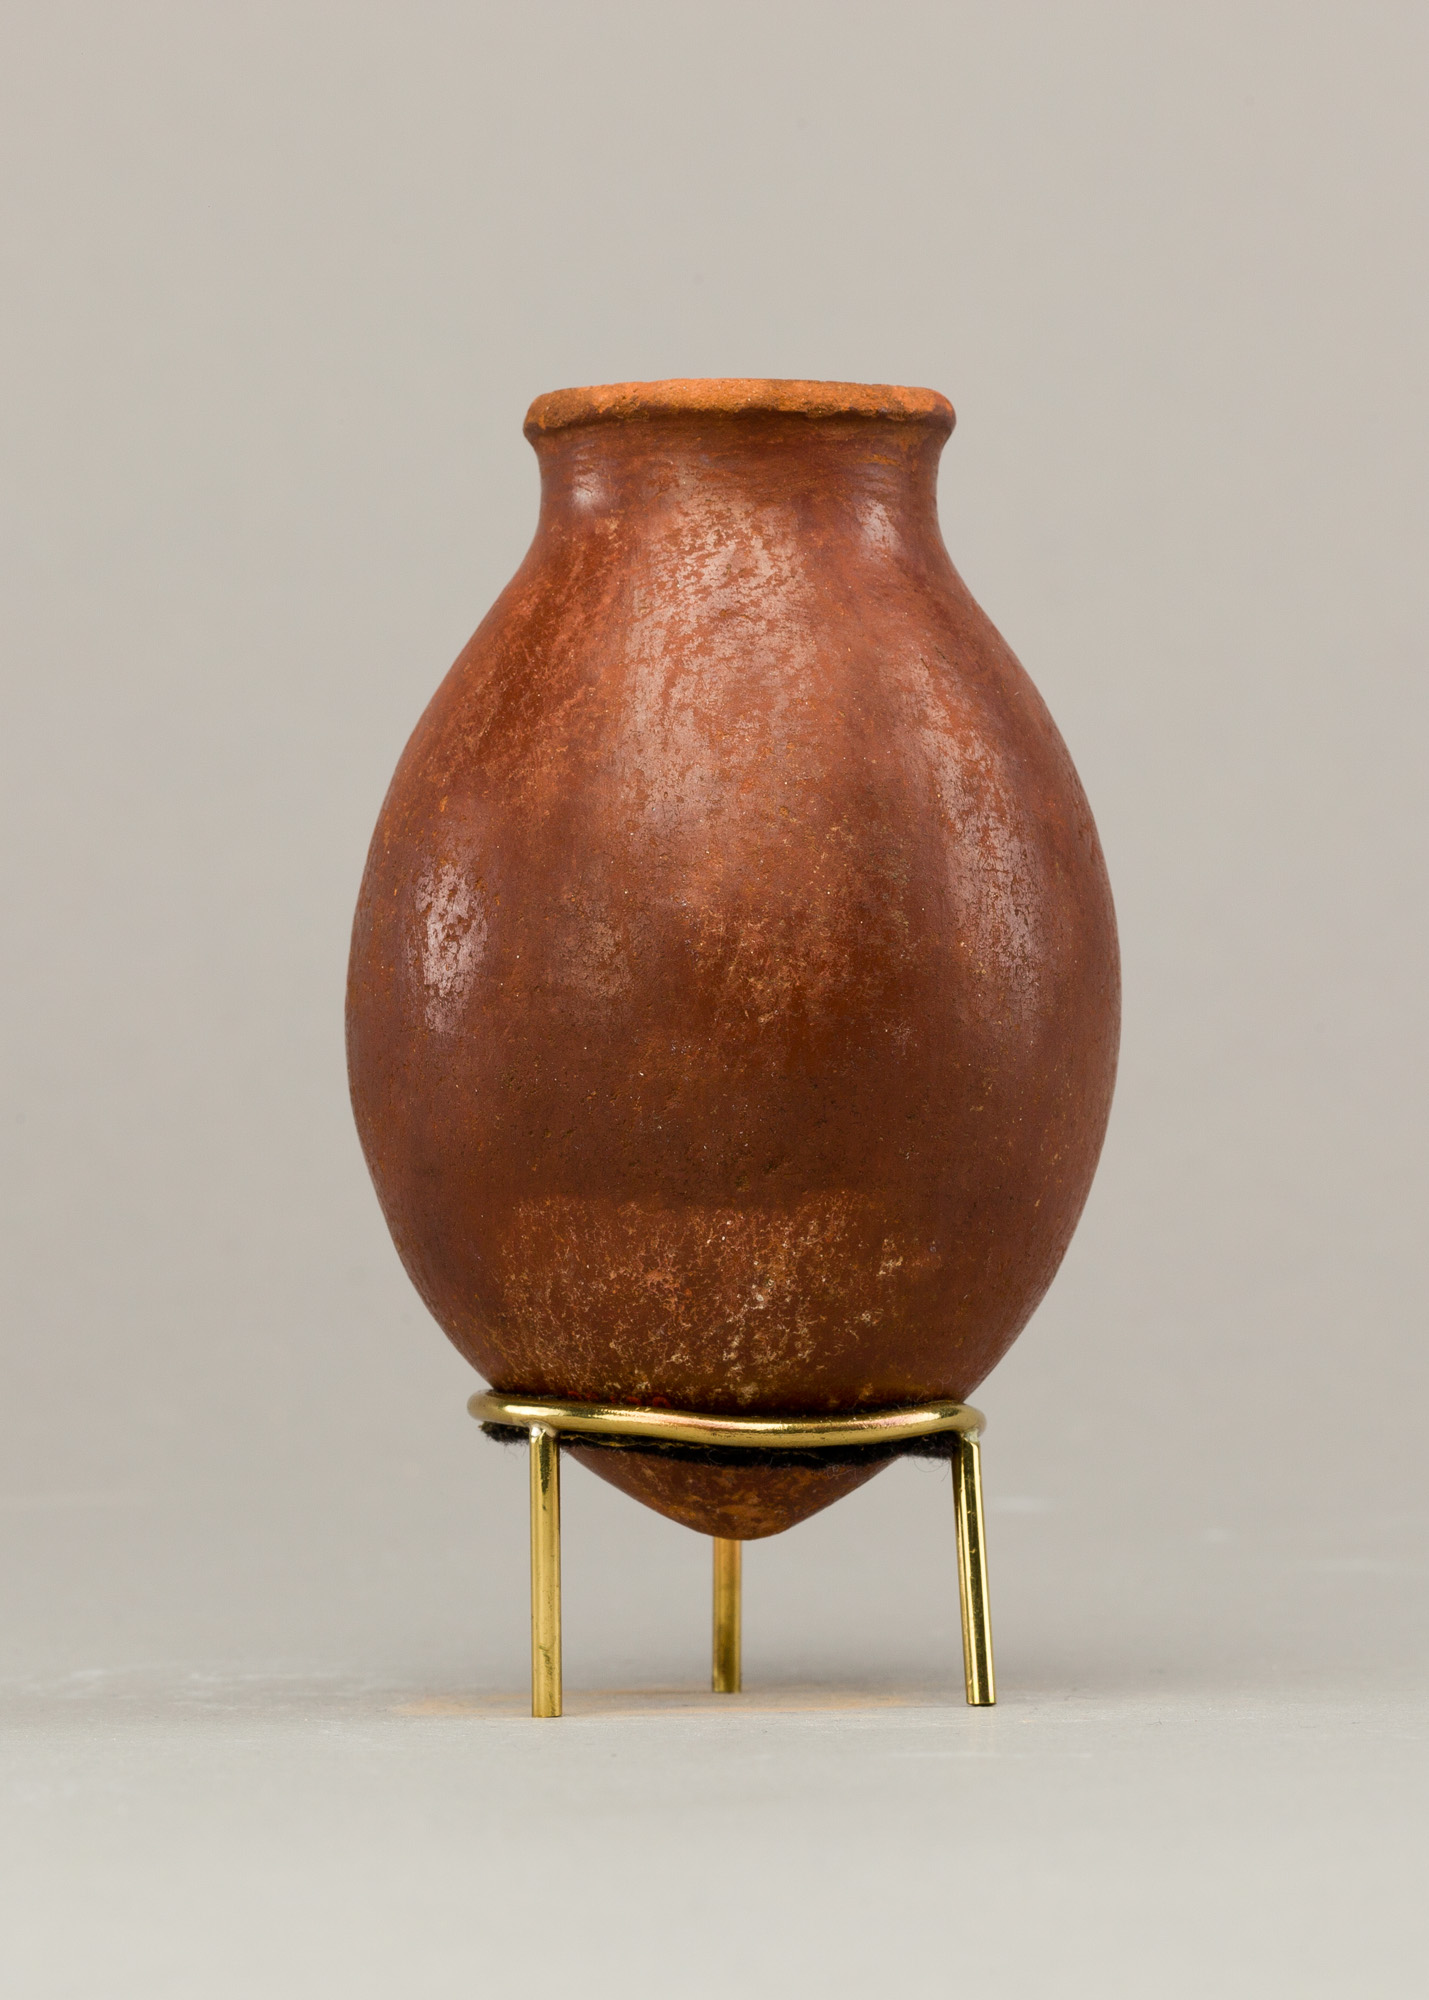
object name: jar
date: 3850-2960 BCE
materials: pottery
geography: egypt